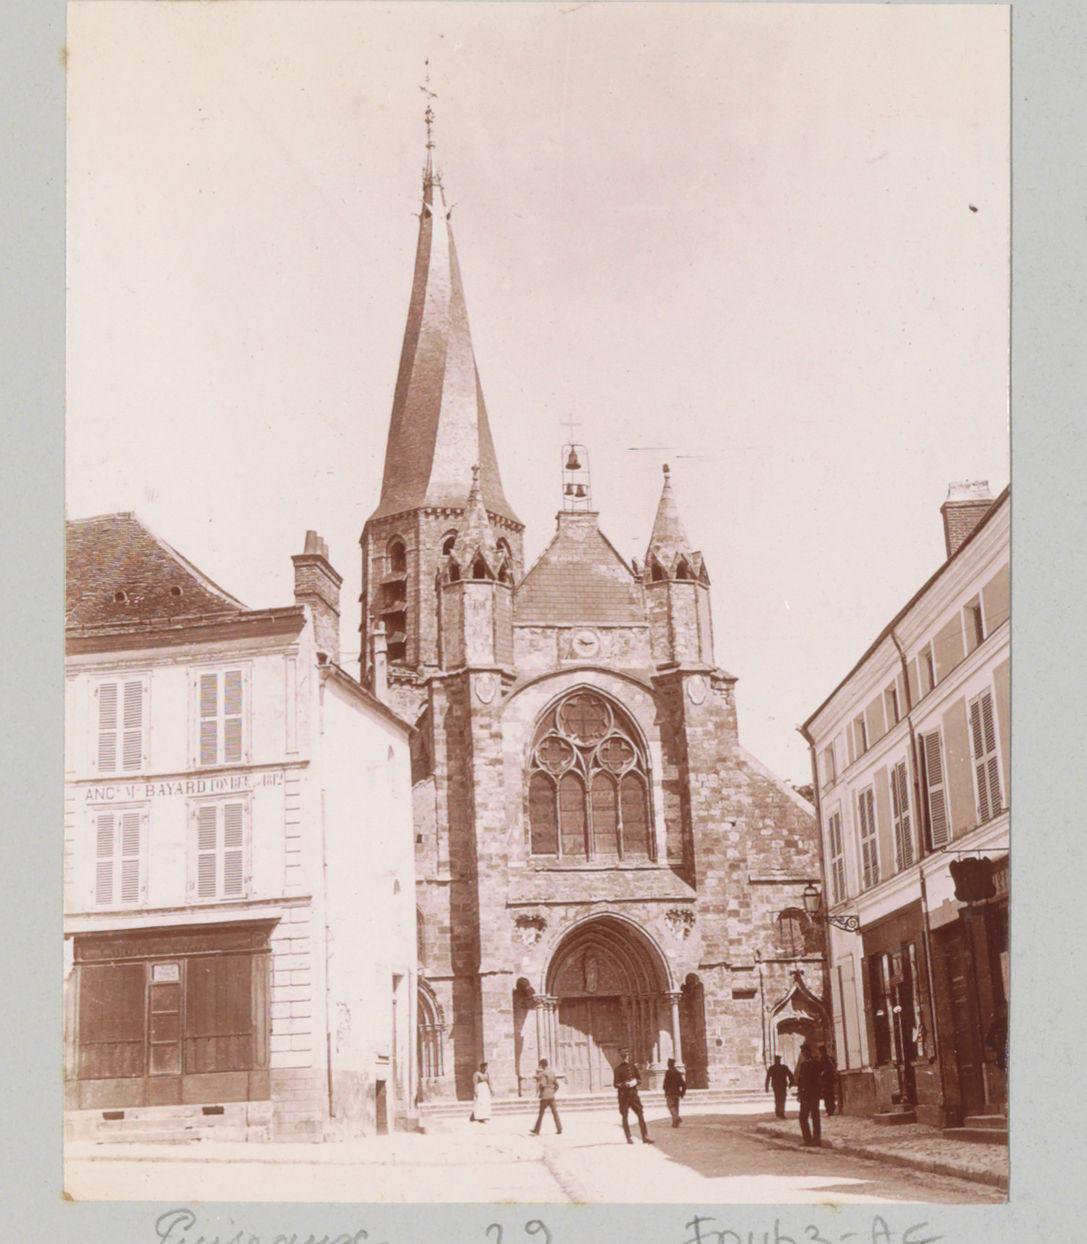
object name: photograph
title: Straat en de kerk Notre-Dame met gedraaide torenspits in Puiseaux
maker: delizy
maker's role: manufacturer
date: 1896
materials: paper, photographic support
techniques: gelatin silver print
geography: puiseaux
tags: church (exterior), parts of church exterior and annexes: spire, street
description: Onderdeel van Fotoalbum van een Franse amateurfotograaf met opnames van uitstapjes in Frankrijk, Spanje, België, Luxemburg en Nederland, de eerste automobielen en autoraces.